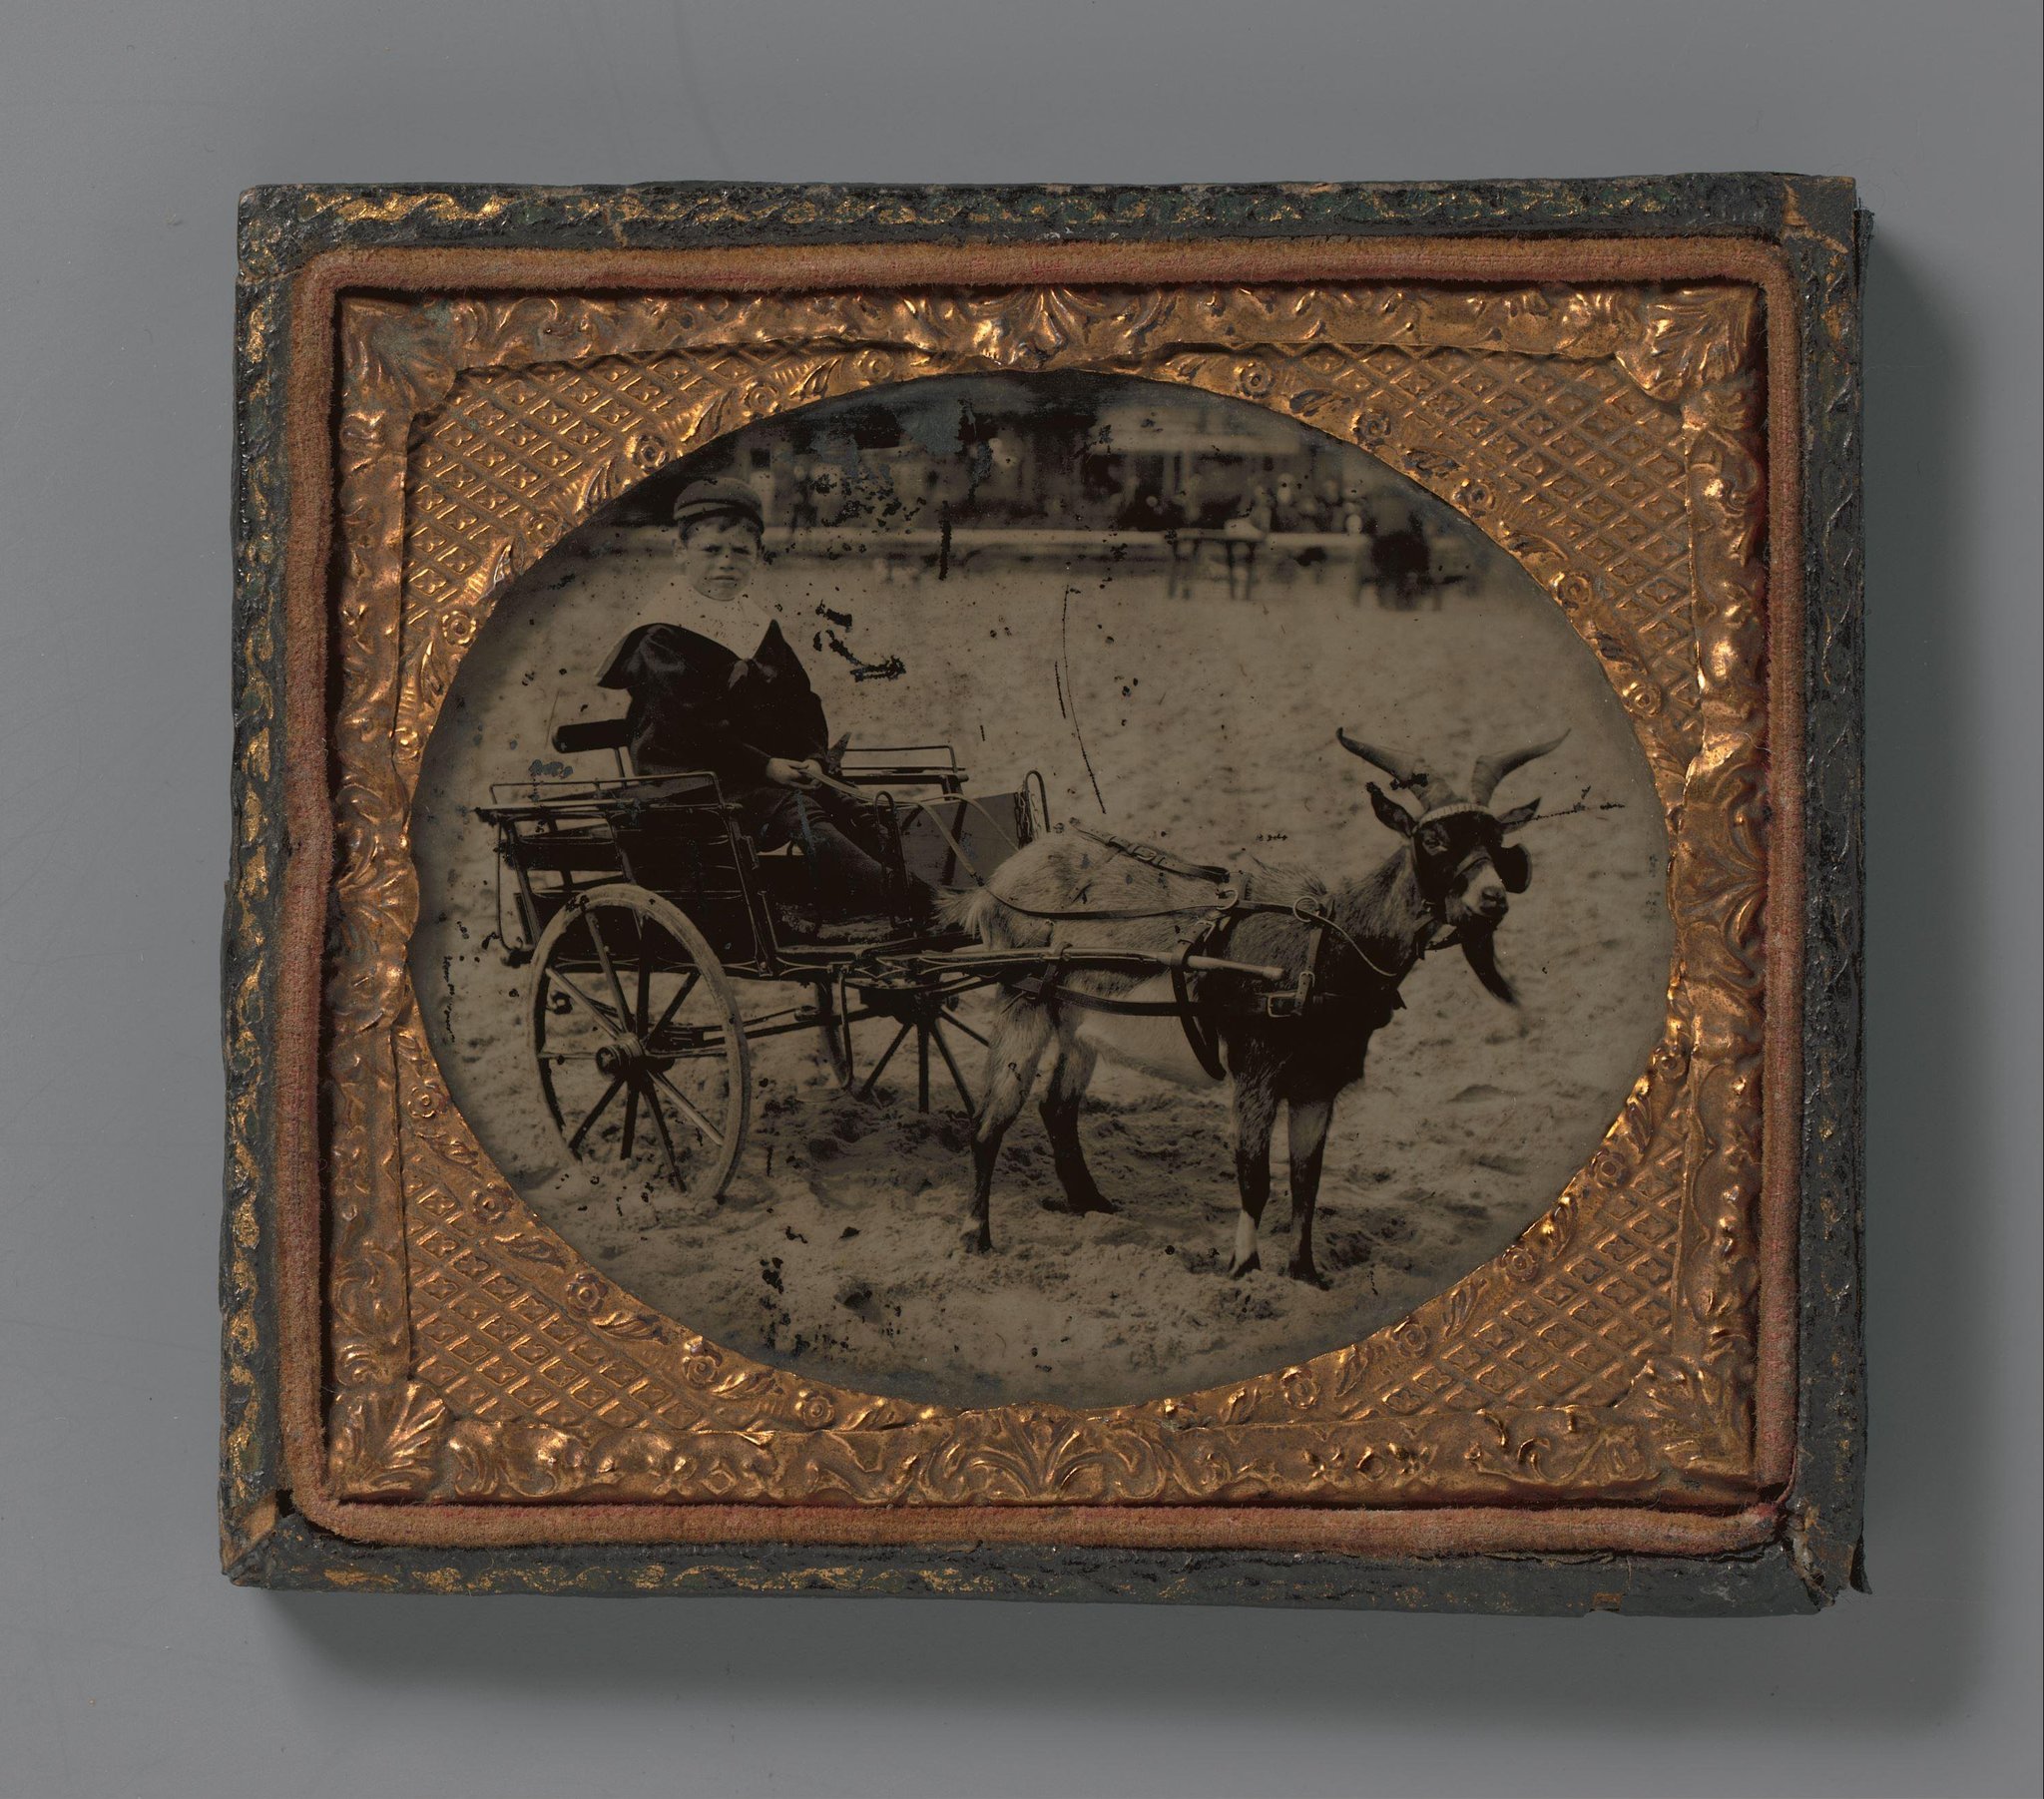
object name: frame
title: Portret van een onbekende jongen in kar voortgetrokken door een geit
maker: Anonymous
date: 1855-1870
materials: glass, metal, velvet, wood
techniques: ambrotype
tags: girl (child between toddler and youth), goat, two-wheeled vehicle drawn by one animal